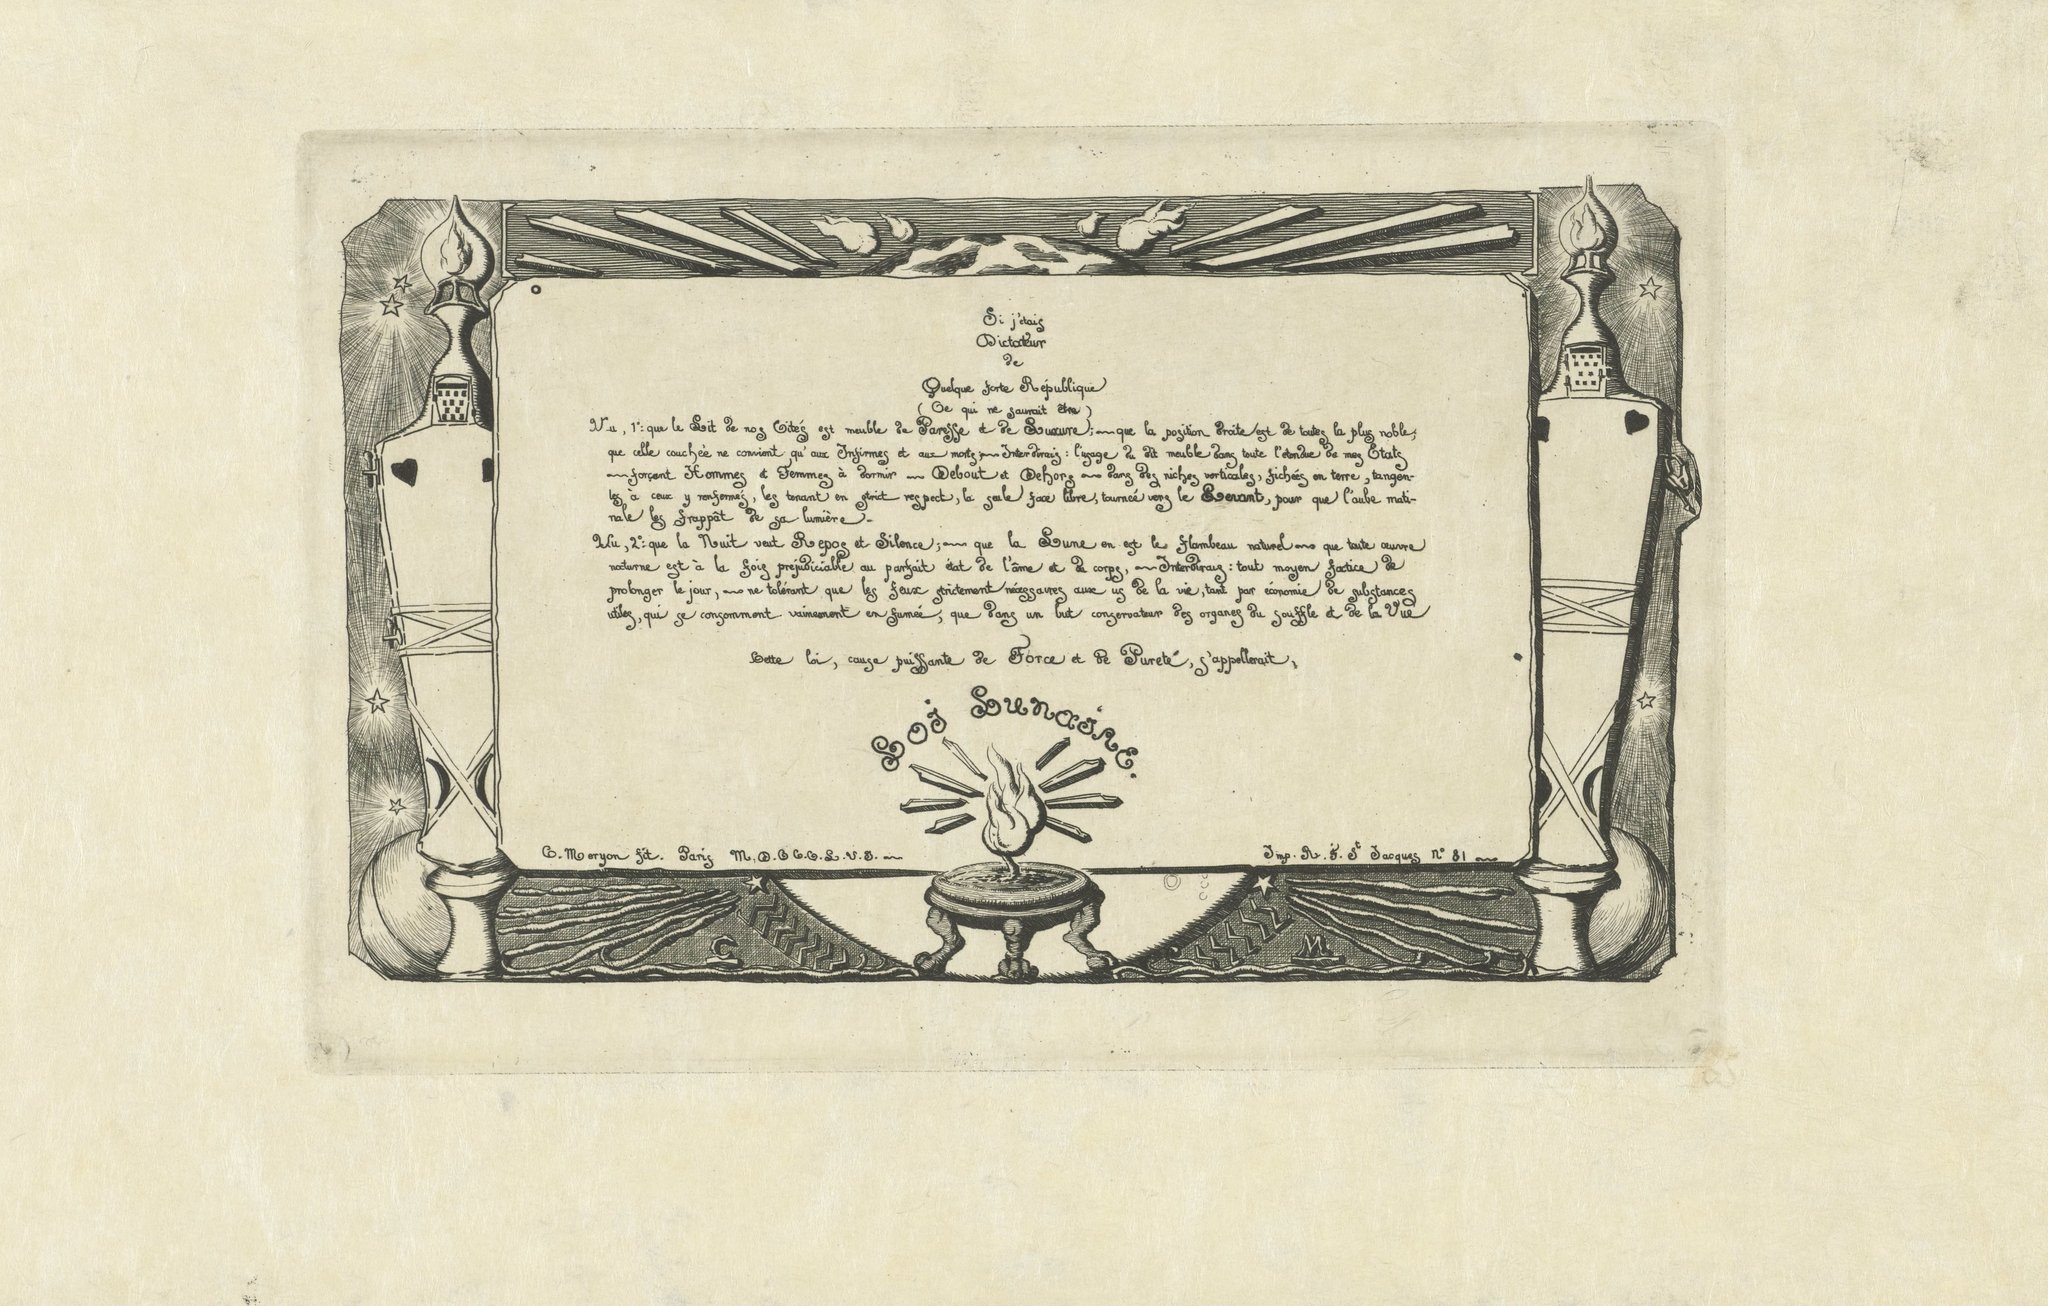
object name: print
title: Pamflet met Loi Lunaire geflankeerd door toortsen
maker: charles meryon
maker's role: print maker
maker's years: 1821-1868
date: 1856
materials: paper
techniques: etching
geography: france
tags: torch, burning, the heavens (celestial bodies)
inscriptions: collector's mark: ‘Andre Sylvio Samama’, collector's mark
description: Pamflet met tekst van Charles Meryon over zijn Loi Lunaire waarin hij zijn visie geeft op het belang van zonlicht en verse lucht voor de mens. Volgens hem heeft de mens veel baat bij rechtop slapen en minder gebruik van kunstmatige lichtbronnen. Op een pamflet zijn negen regels tekst geschreven: Si j'étais Dictateur ... s'appellerait, Loi Lunaire. Het pamflet wordt geflankeerd door twee toortsen en rond het blad zijn hemellichamen weergegeven, verwijzend naar de natuurlijke lichtbronnen welke in de tekst genoemd worden. In het midden onder staat een brandende olielamp die volgens de wet spaarzamer gebruikt moet worden.